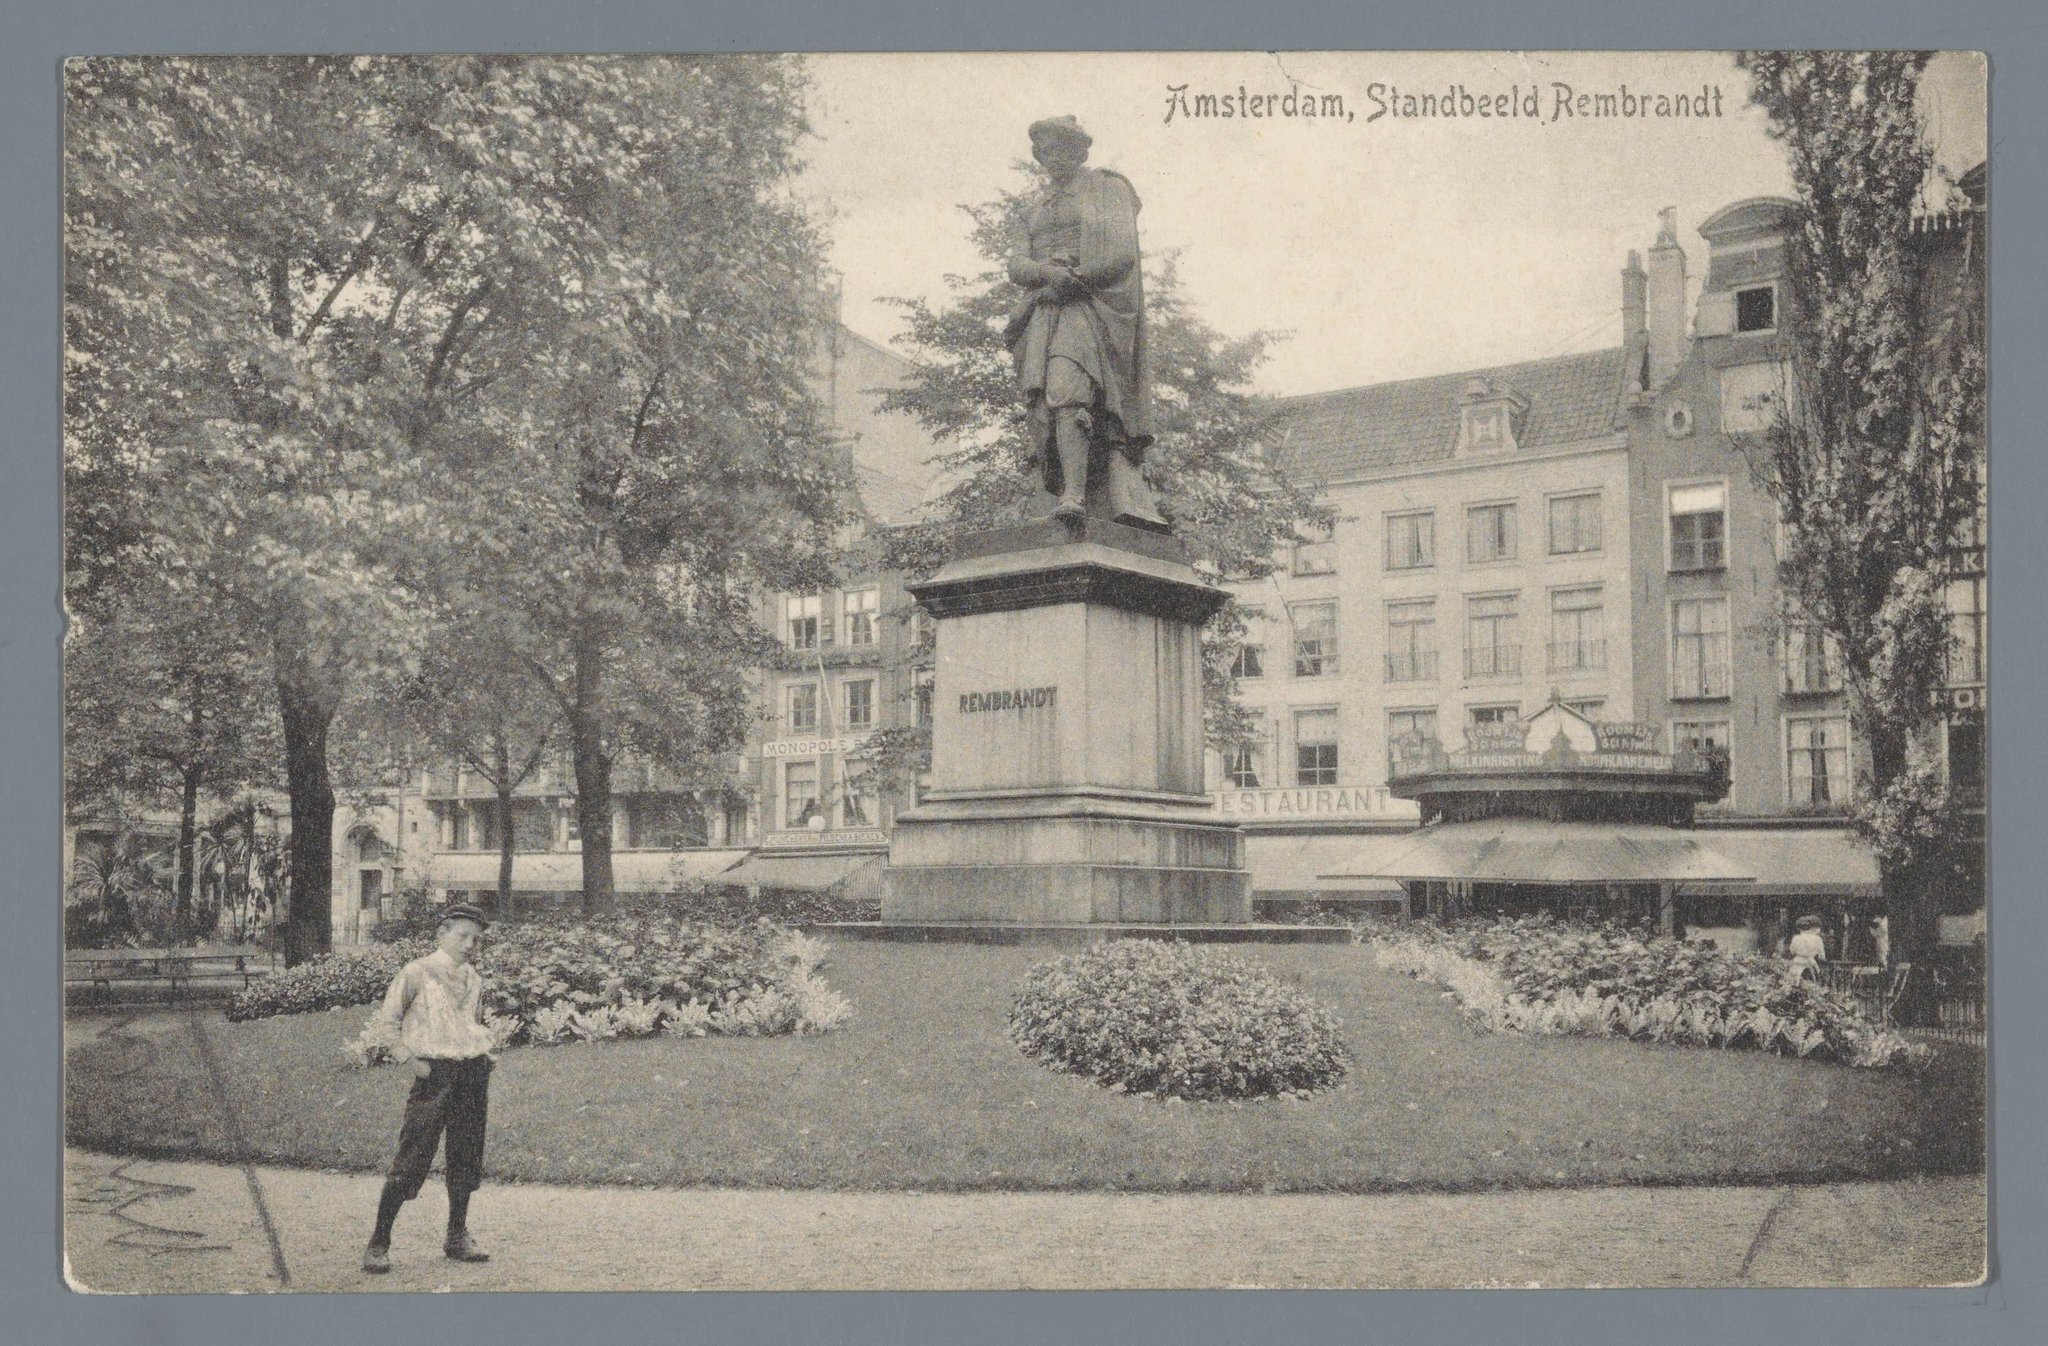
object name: ansichtkaart, prentbriefkaart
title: Amsterdam, Standbeeld Rembrandt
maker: vsm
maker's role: fotograaf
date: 1875-1930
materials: cardboard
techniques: photograph, writing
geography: amsterdam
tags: amsterdam, draughtsman, rembrandt van rijn, park, monument, statue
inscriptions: number: ‘9126’